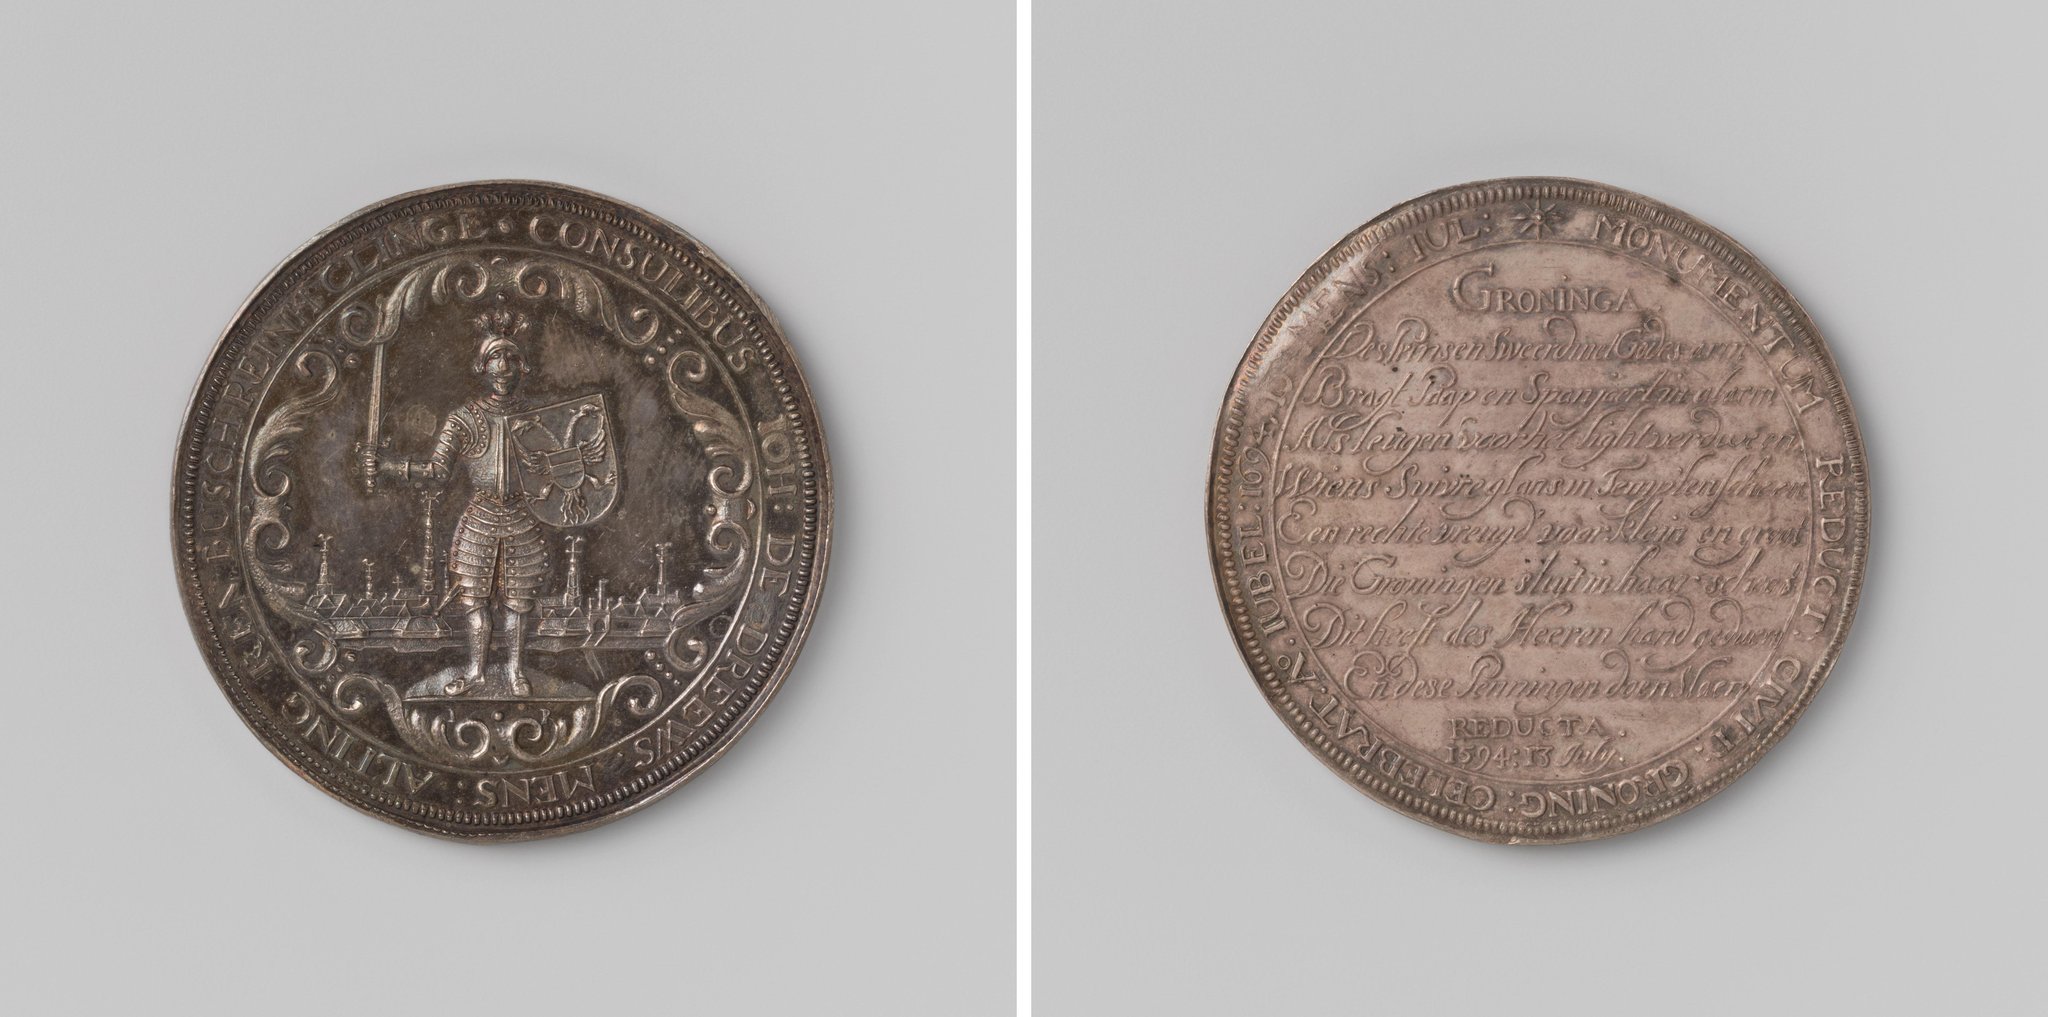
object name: history medal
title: Herdenking van de bevrijding van Groningen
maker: johann von reckingen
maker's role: medailleur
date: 1694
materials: silver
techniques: striking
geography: emden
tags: groningen, reductie van groningen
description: Zilveren penning. Voorzijde: geharnaste soldaat met zwaard en wapenschild, op achtergrond gezicht op stad binnen sierrand en omschrift. Keerzijde: opschrift binnen omschrift